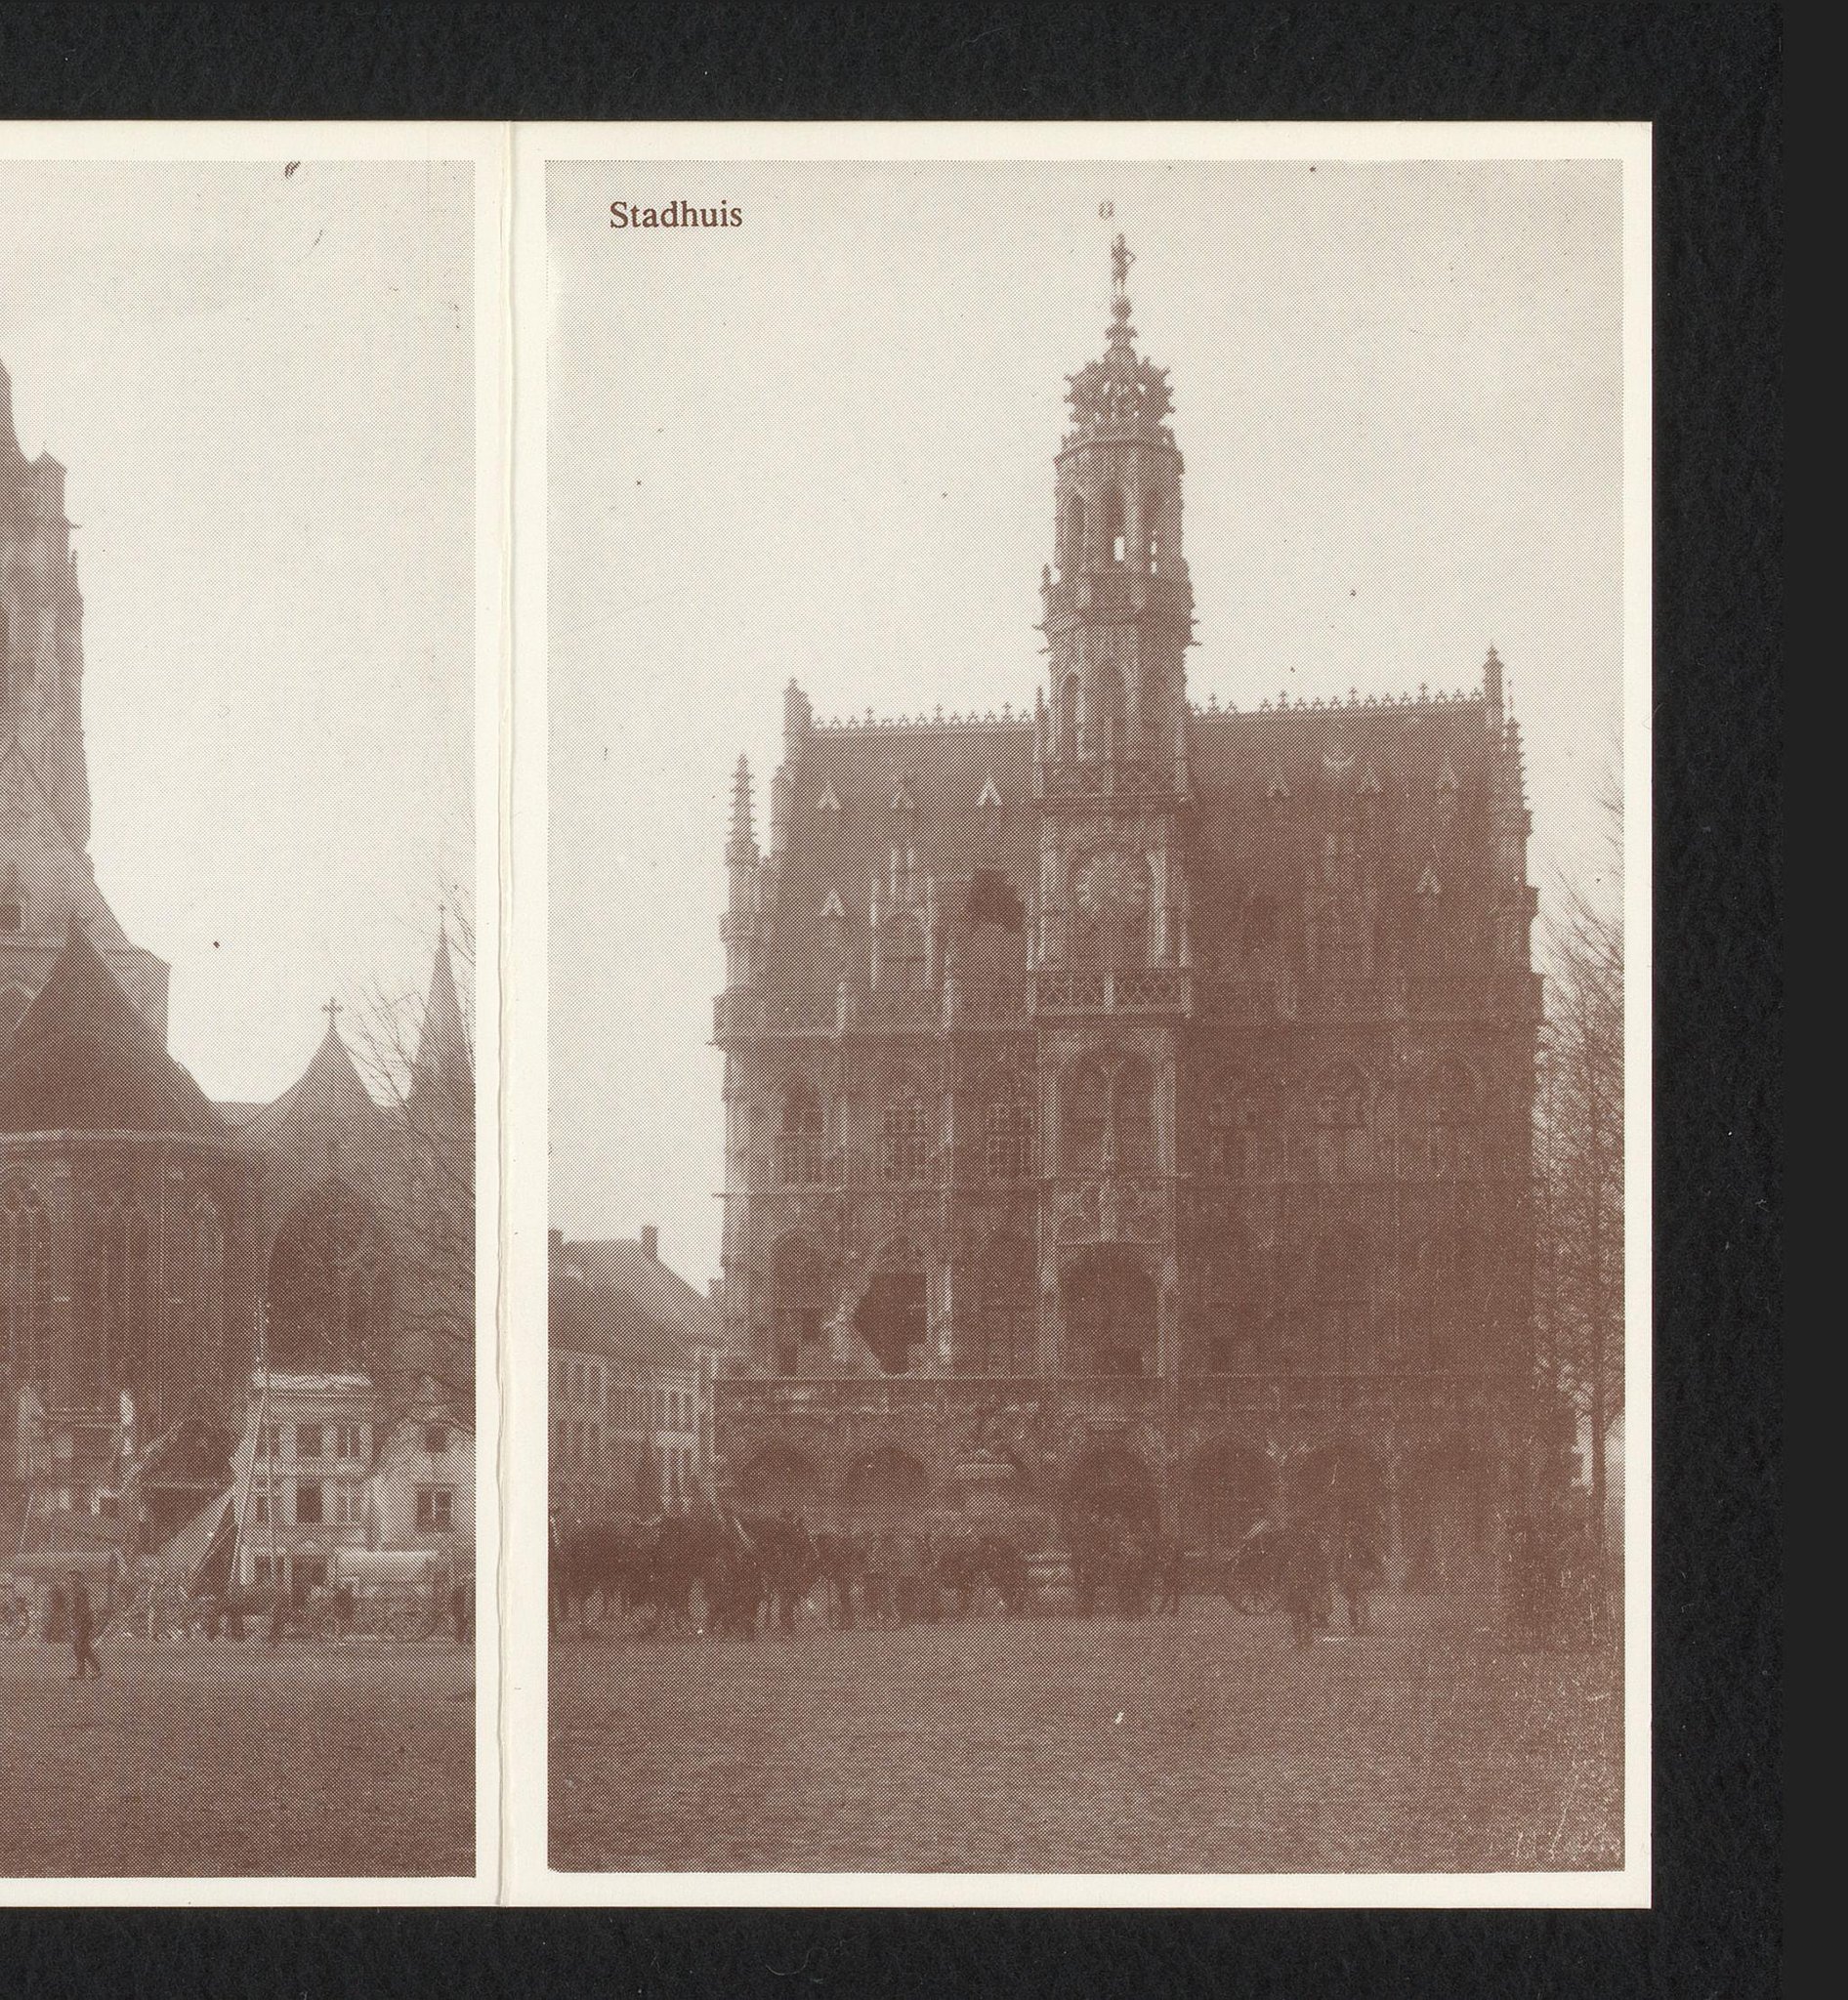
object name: ansichtkaart, prentbriefkaart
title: Stadhuis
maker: Anonymous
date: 1981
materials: cardboard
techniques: offset printed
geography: oudenaarde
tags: townhall, consequences of war, city-view, and landscape with man-made constructions (+ city(-scape) with figures, staffage)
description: Deze prentbriefkaart is een reproductie van een oudere prentbriefkaart.